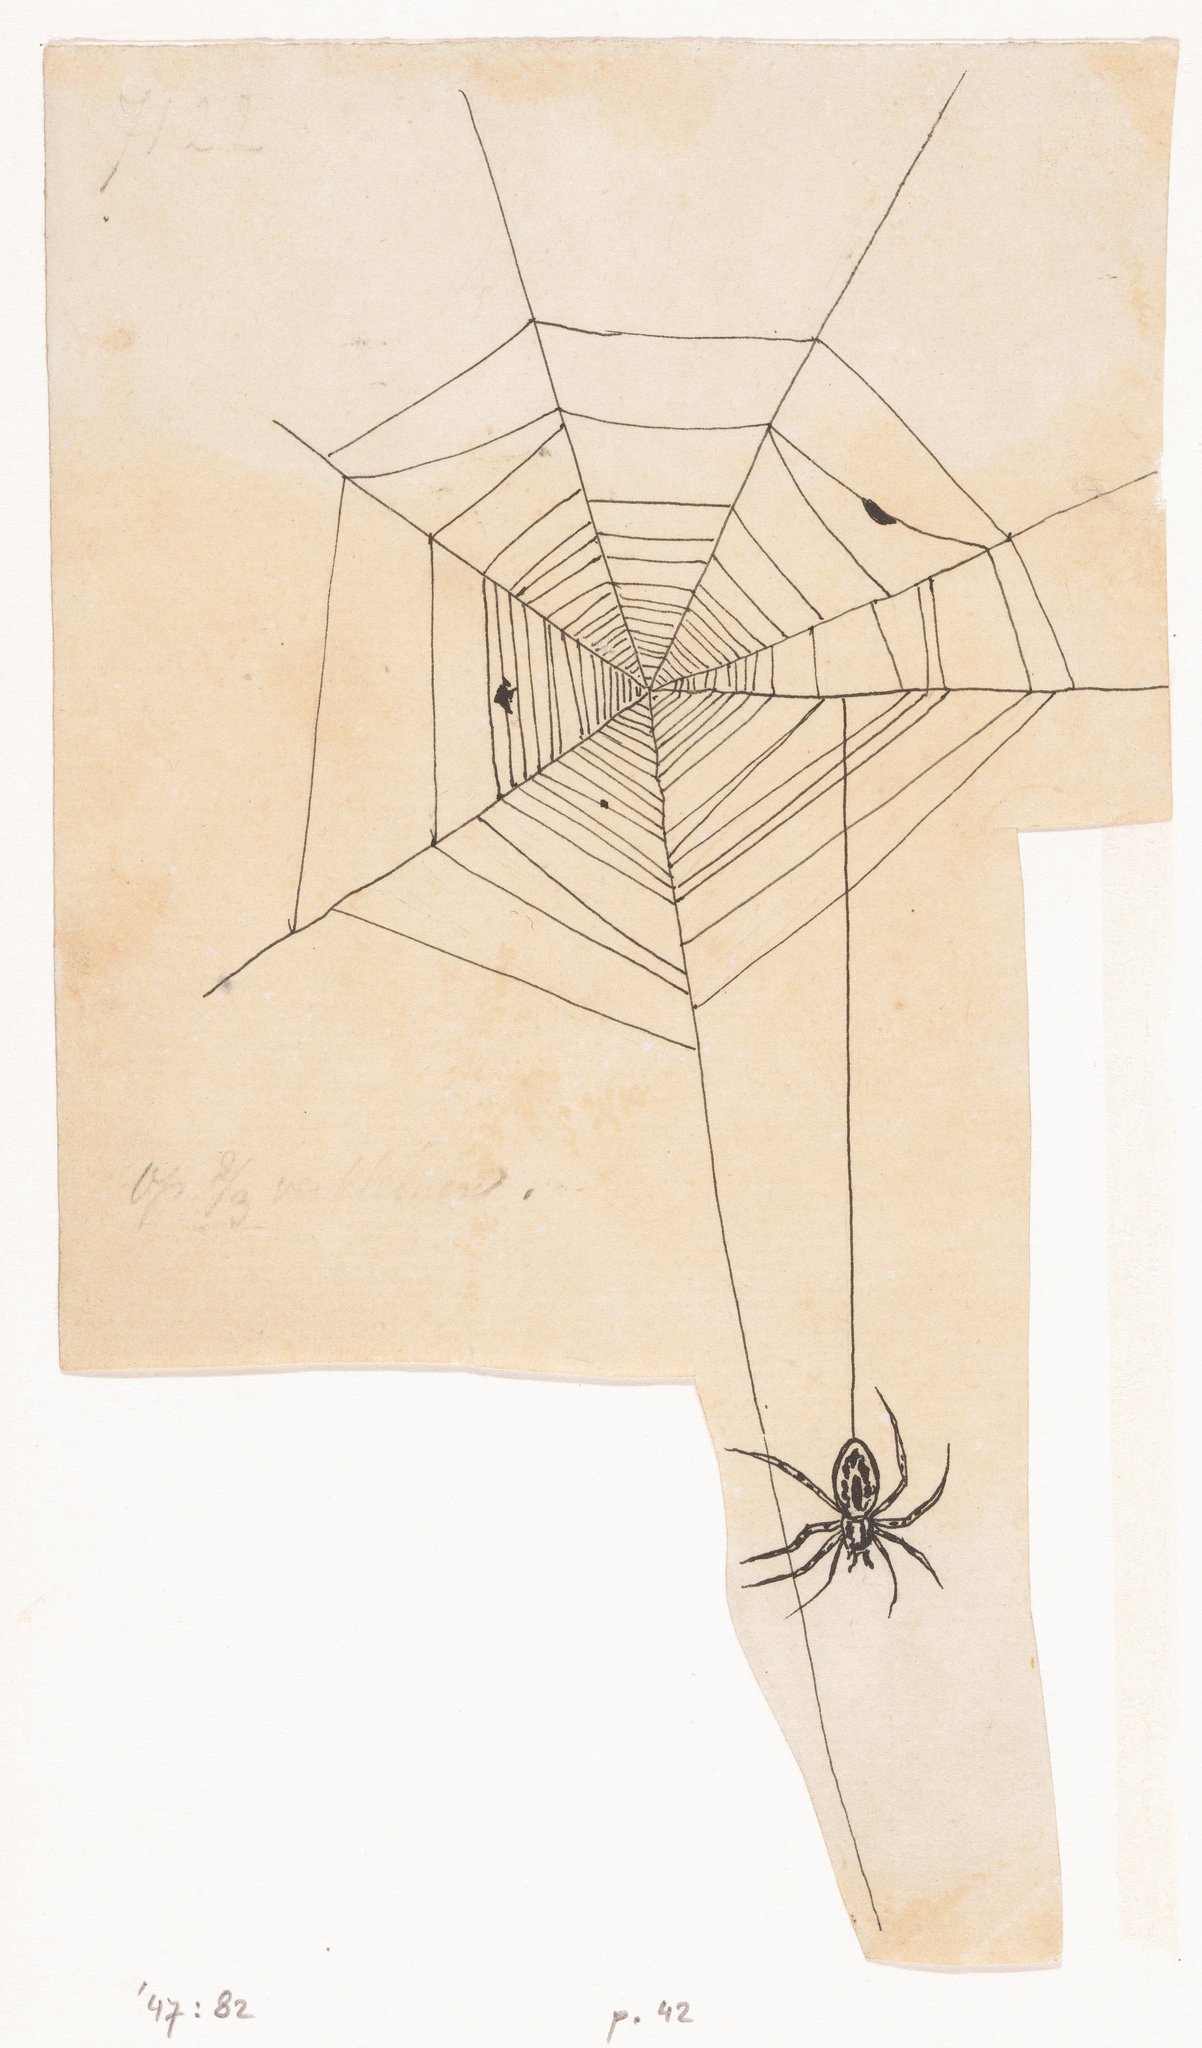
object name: drawing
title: Spinnenweb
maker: willem wenckebach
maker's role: designer, draughtsman, painter, print maker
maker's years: 1860-1937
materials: ink, paper, pencil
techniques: pen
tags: spiders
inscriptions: :, collector's mark: Lugt 2228a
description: Ontwerp voor: Knappert, Emilie C. Kijkjes in de plantenwereld. Loman & Funke: Amsterdam, 1893.